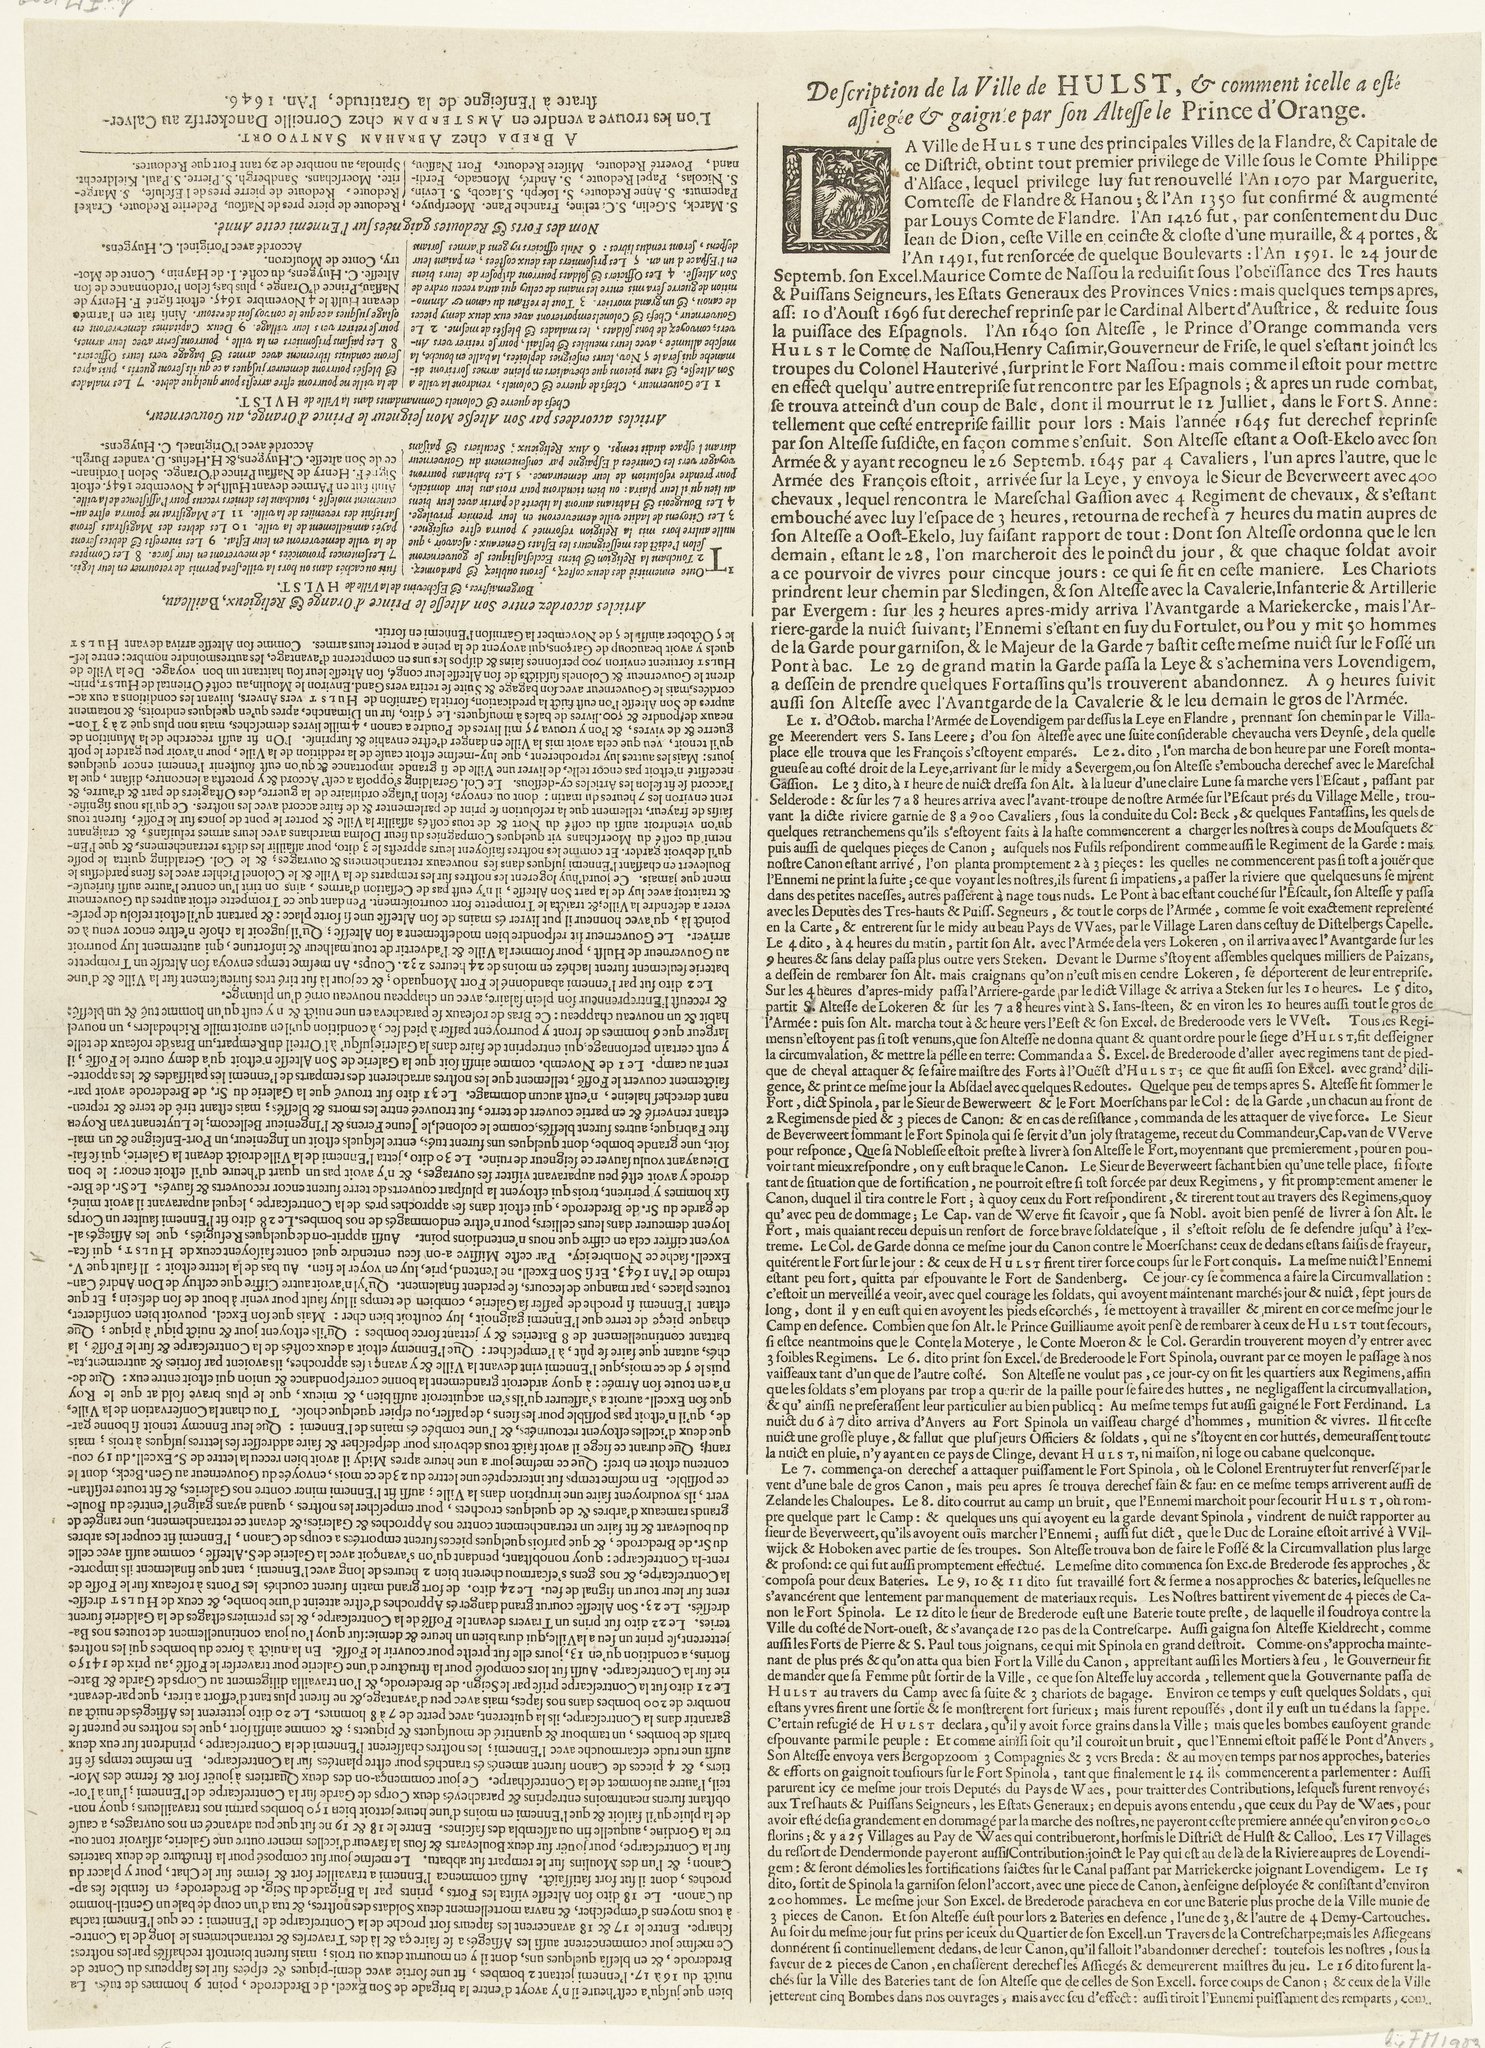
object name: text sheet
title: Beleg en verovering van Hulst door Frederik Hendrik (tekstblad), 1645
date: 1646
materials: paper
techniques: letterpress printing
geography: amsterdam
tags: delft, the hague, frederick henry (prince of orange)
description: Beleg en verovering van Hulst door het Staatse leger onder Frederik Hendrik van 28 september tot 5 november 1645. Onversneden tekstblad met beschrijving van de gebeurtenissen in 2 kolommen in het Frans. Onderdeel van een ongemonteerd ensemble bestaande uit de grote kaart van het beleg in 4 bladen, een tekstblad in het Frans (het tekstblad in het Nederlands ontbreekt) en de uittocht van het Spaanse garnizoen in 2 bladen.